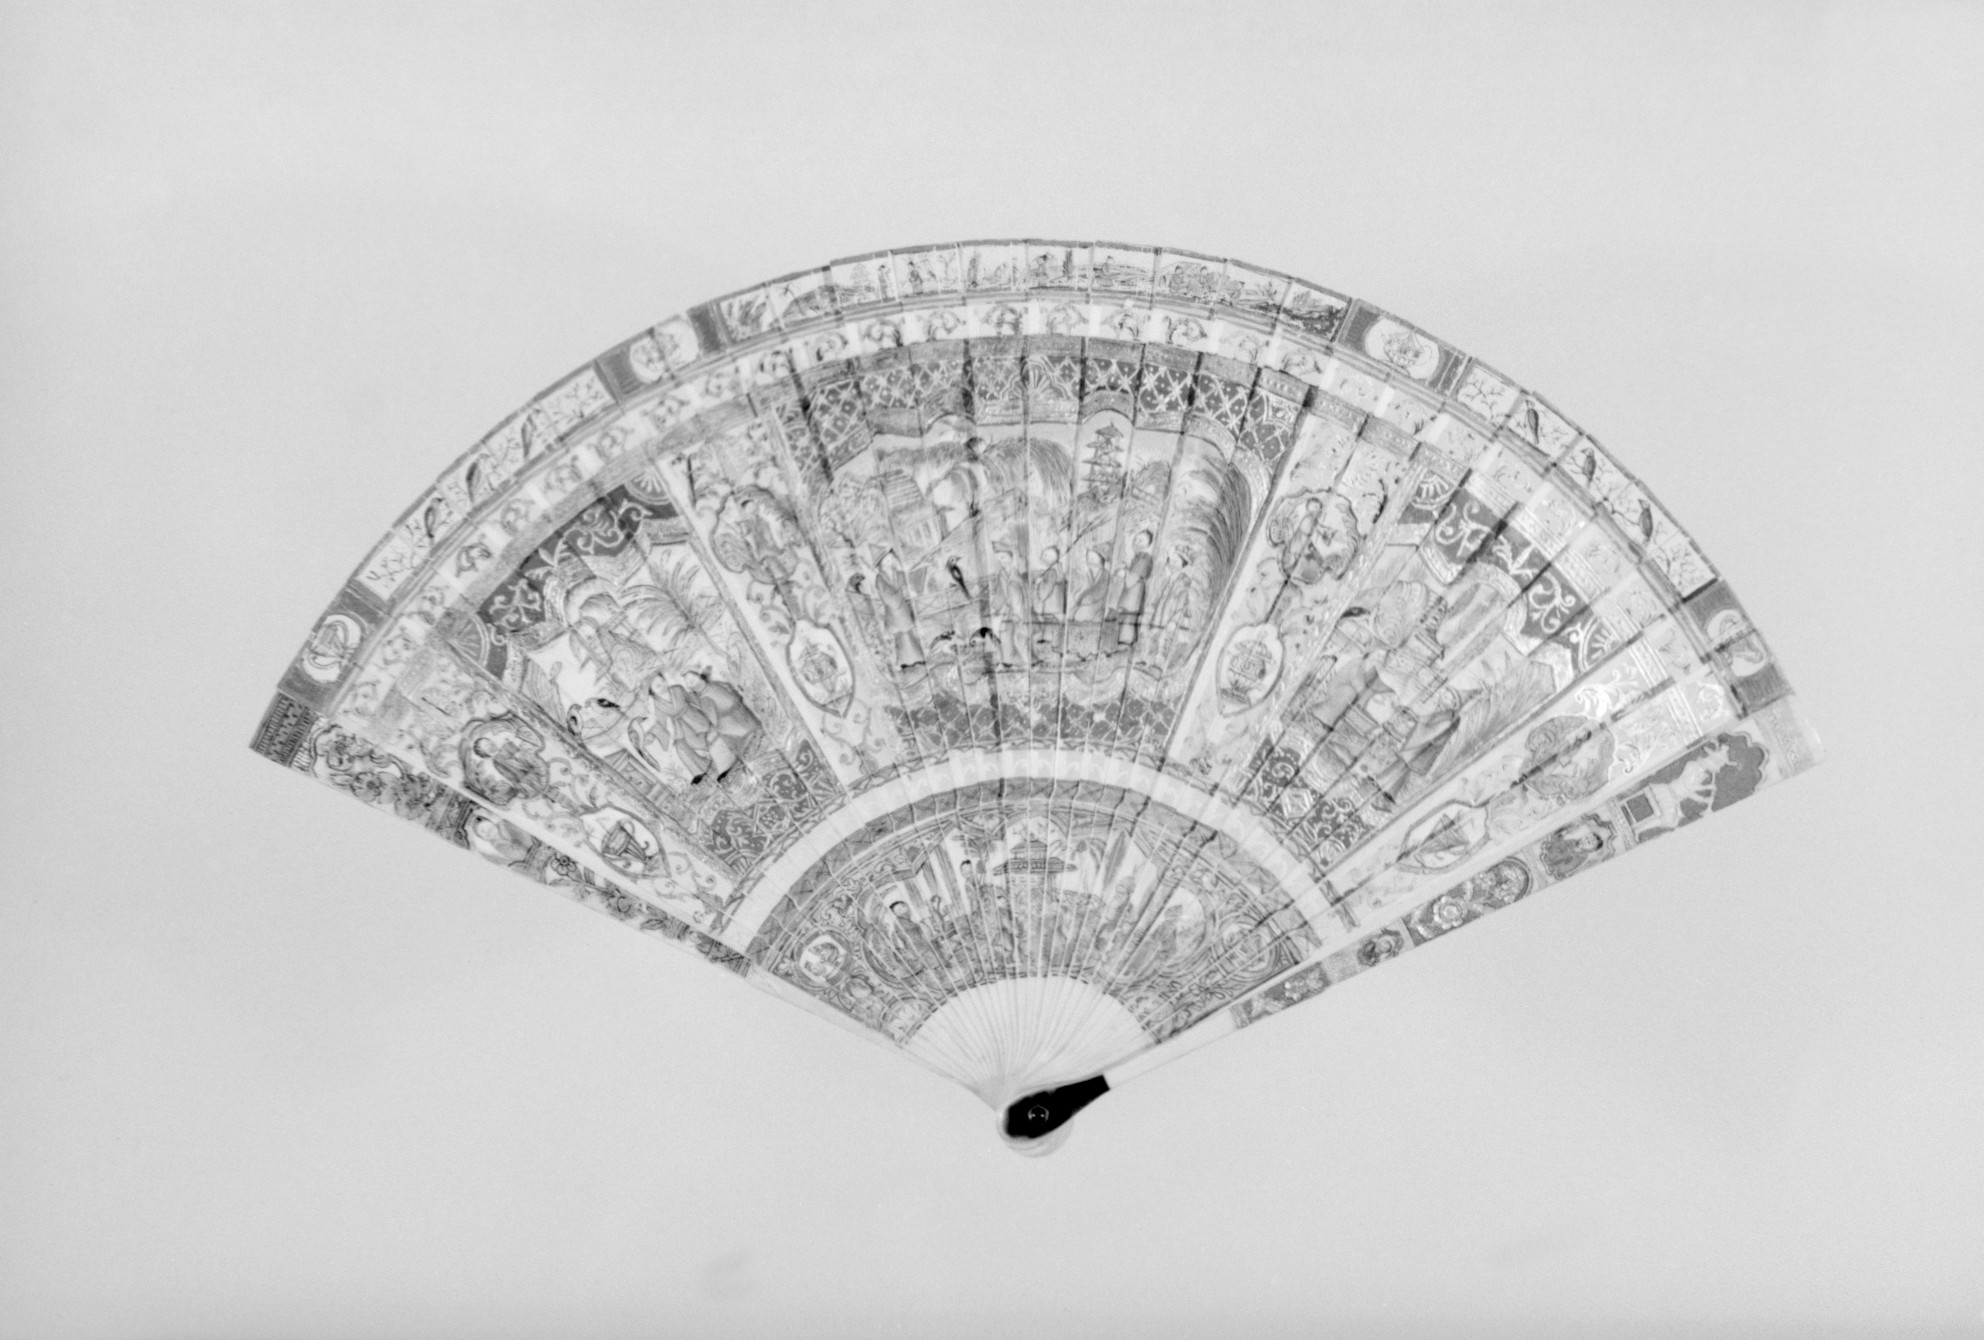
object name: fan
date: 1701-1800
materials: ivory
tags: birds,chinoiserie,men